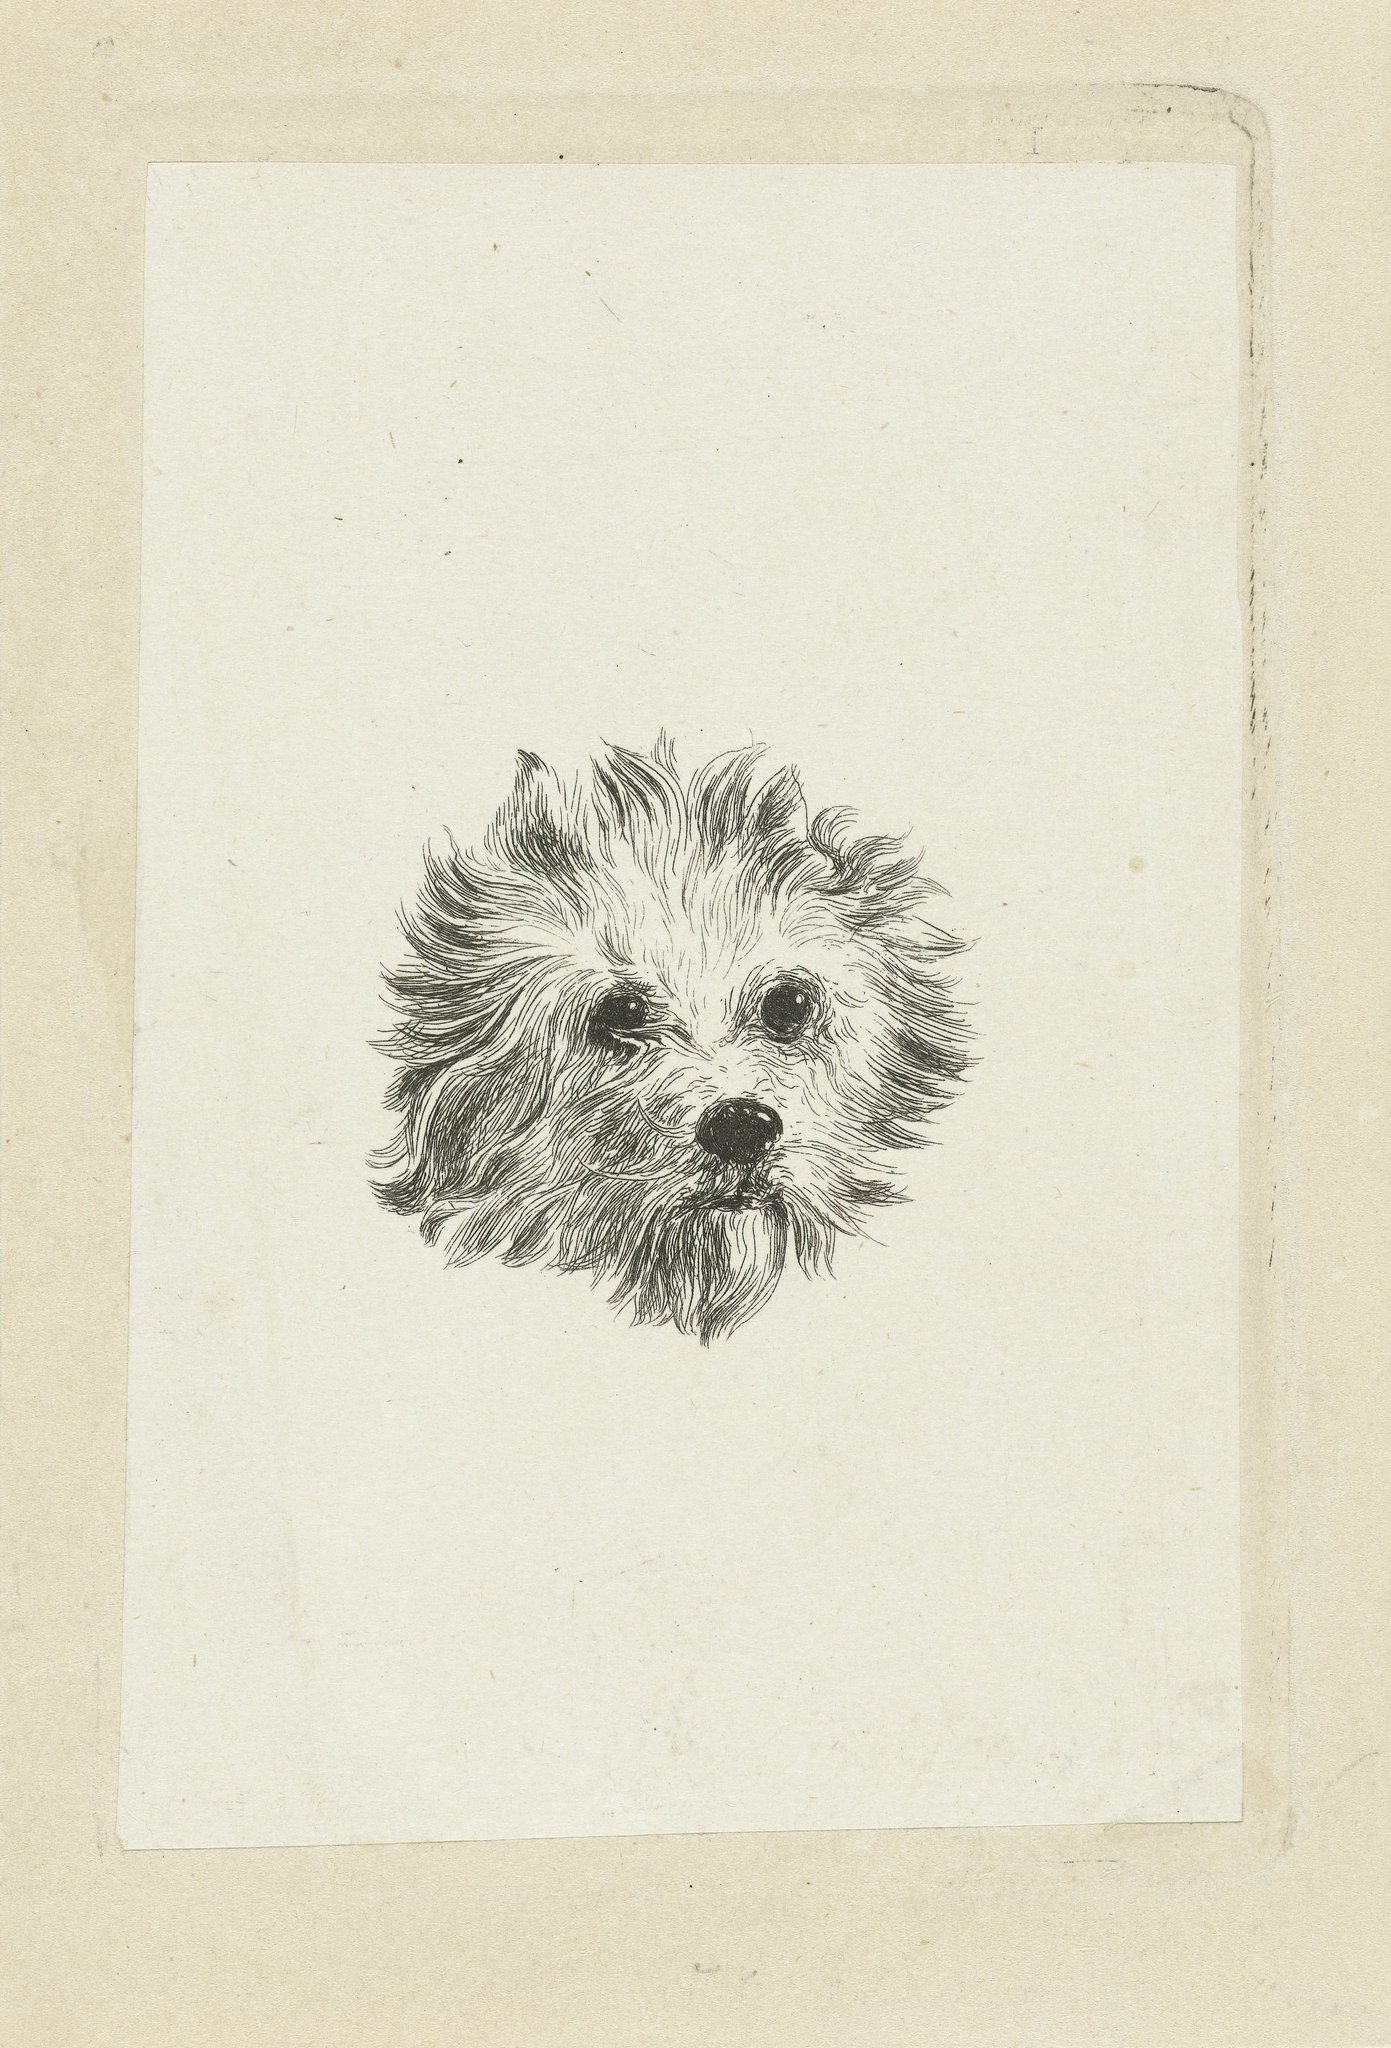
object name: print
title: Kop van hond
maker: eduard cuypers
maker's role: print maker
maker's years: 1859-1927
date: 1869-1927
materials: paper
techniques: etching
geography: netherlands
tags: dog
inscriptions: collector's mark: Lugt 2228